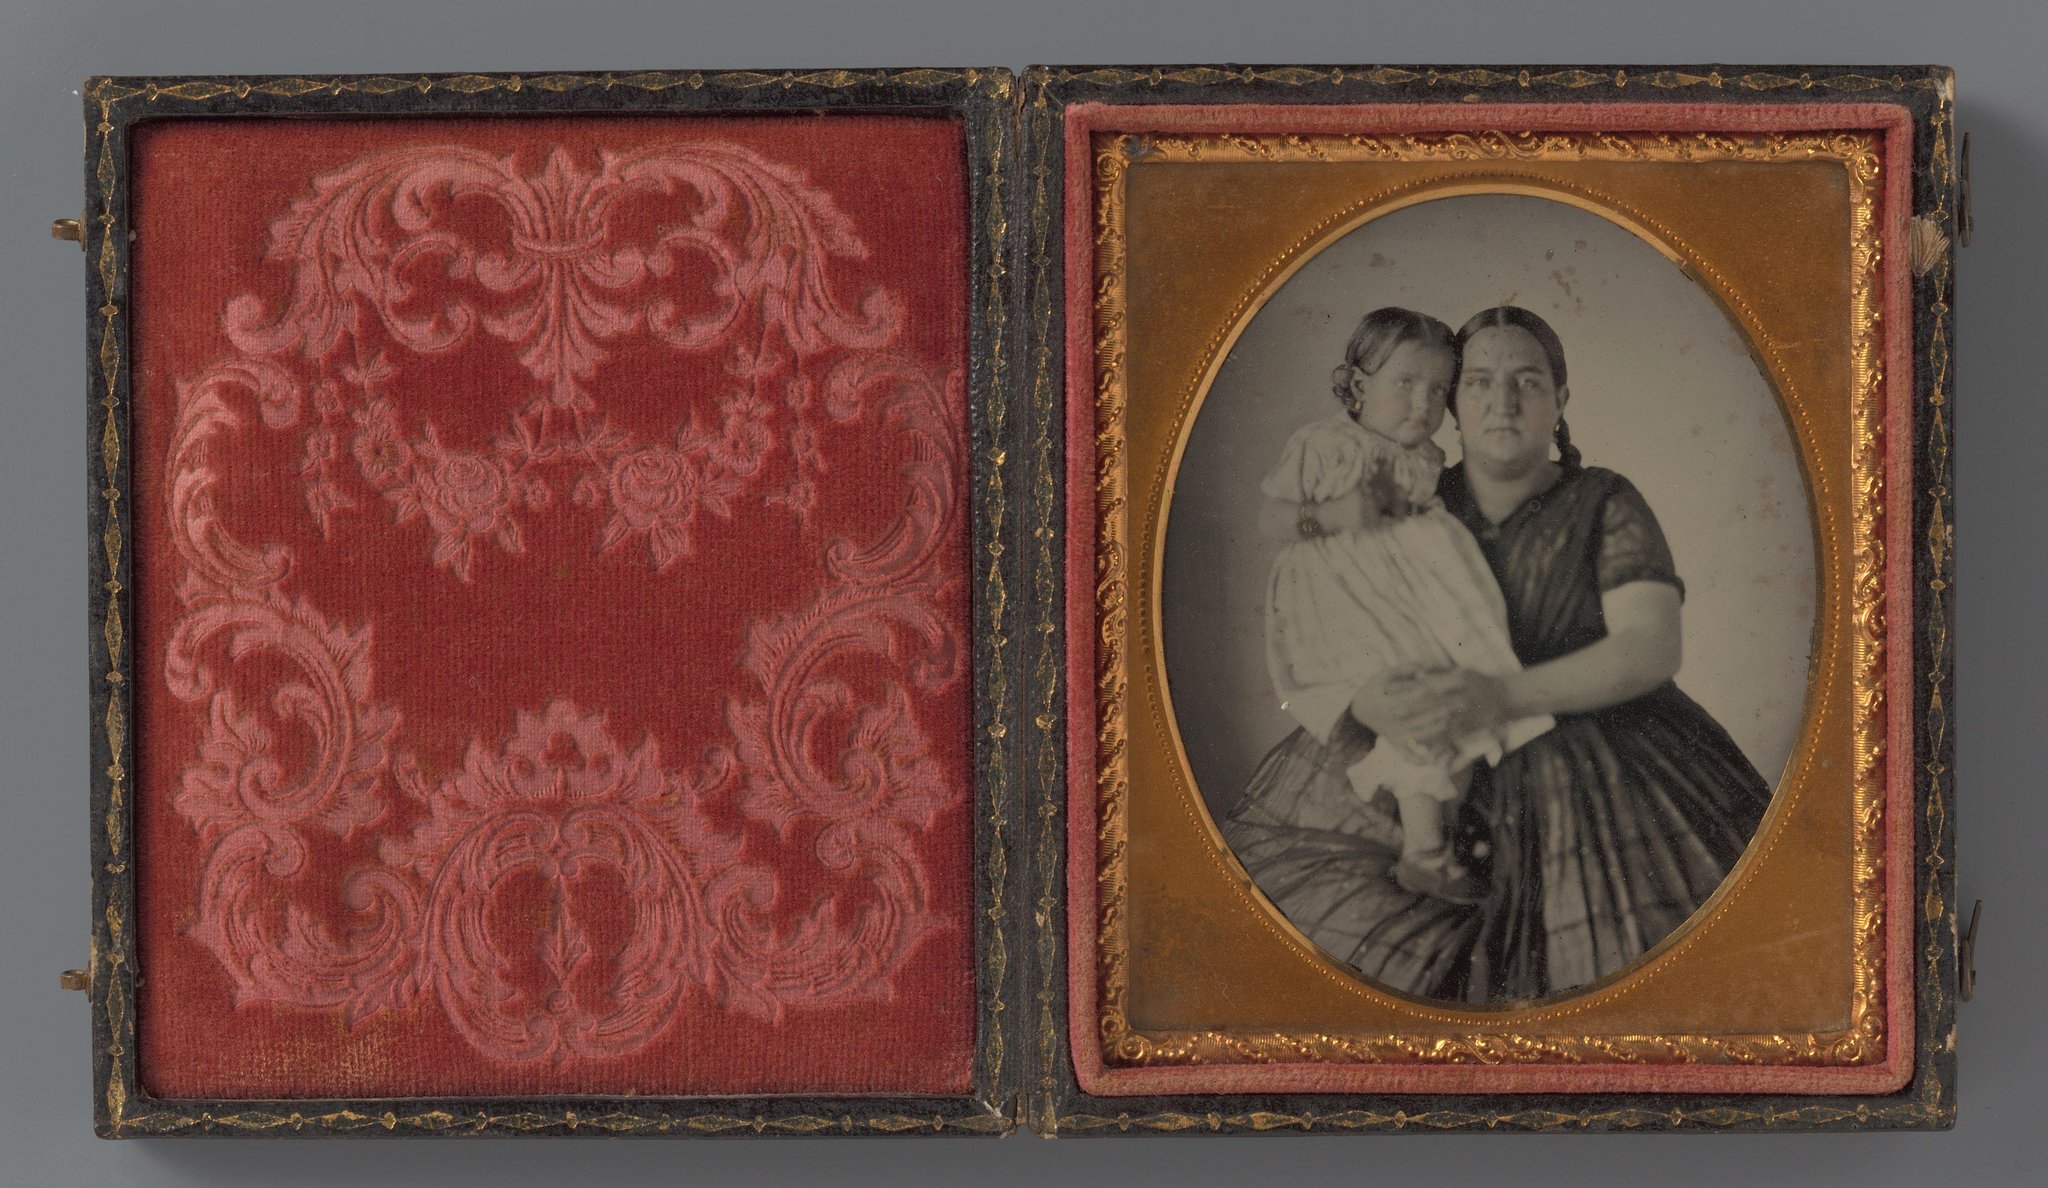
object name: photograph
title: Portret van een onbekende vrouw met kind op de arm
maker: Anonymous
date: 1855-1870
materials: glass, leather, metal, velvet, wood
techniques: ambrotype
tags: historical persons - bb - woman, toddler (female), mother and baby or young child